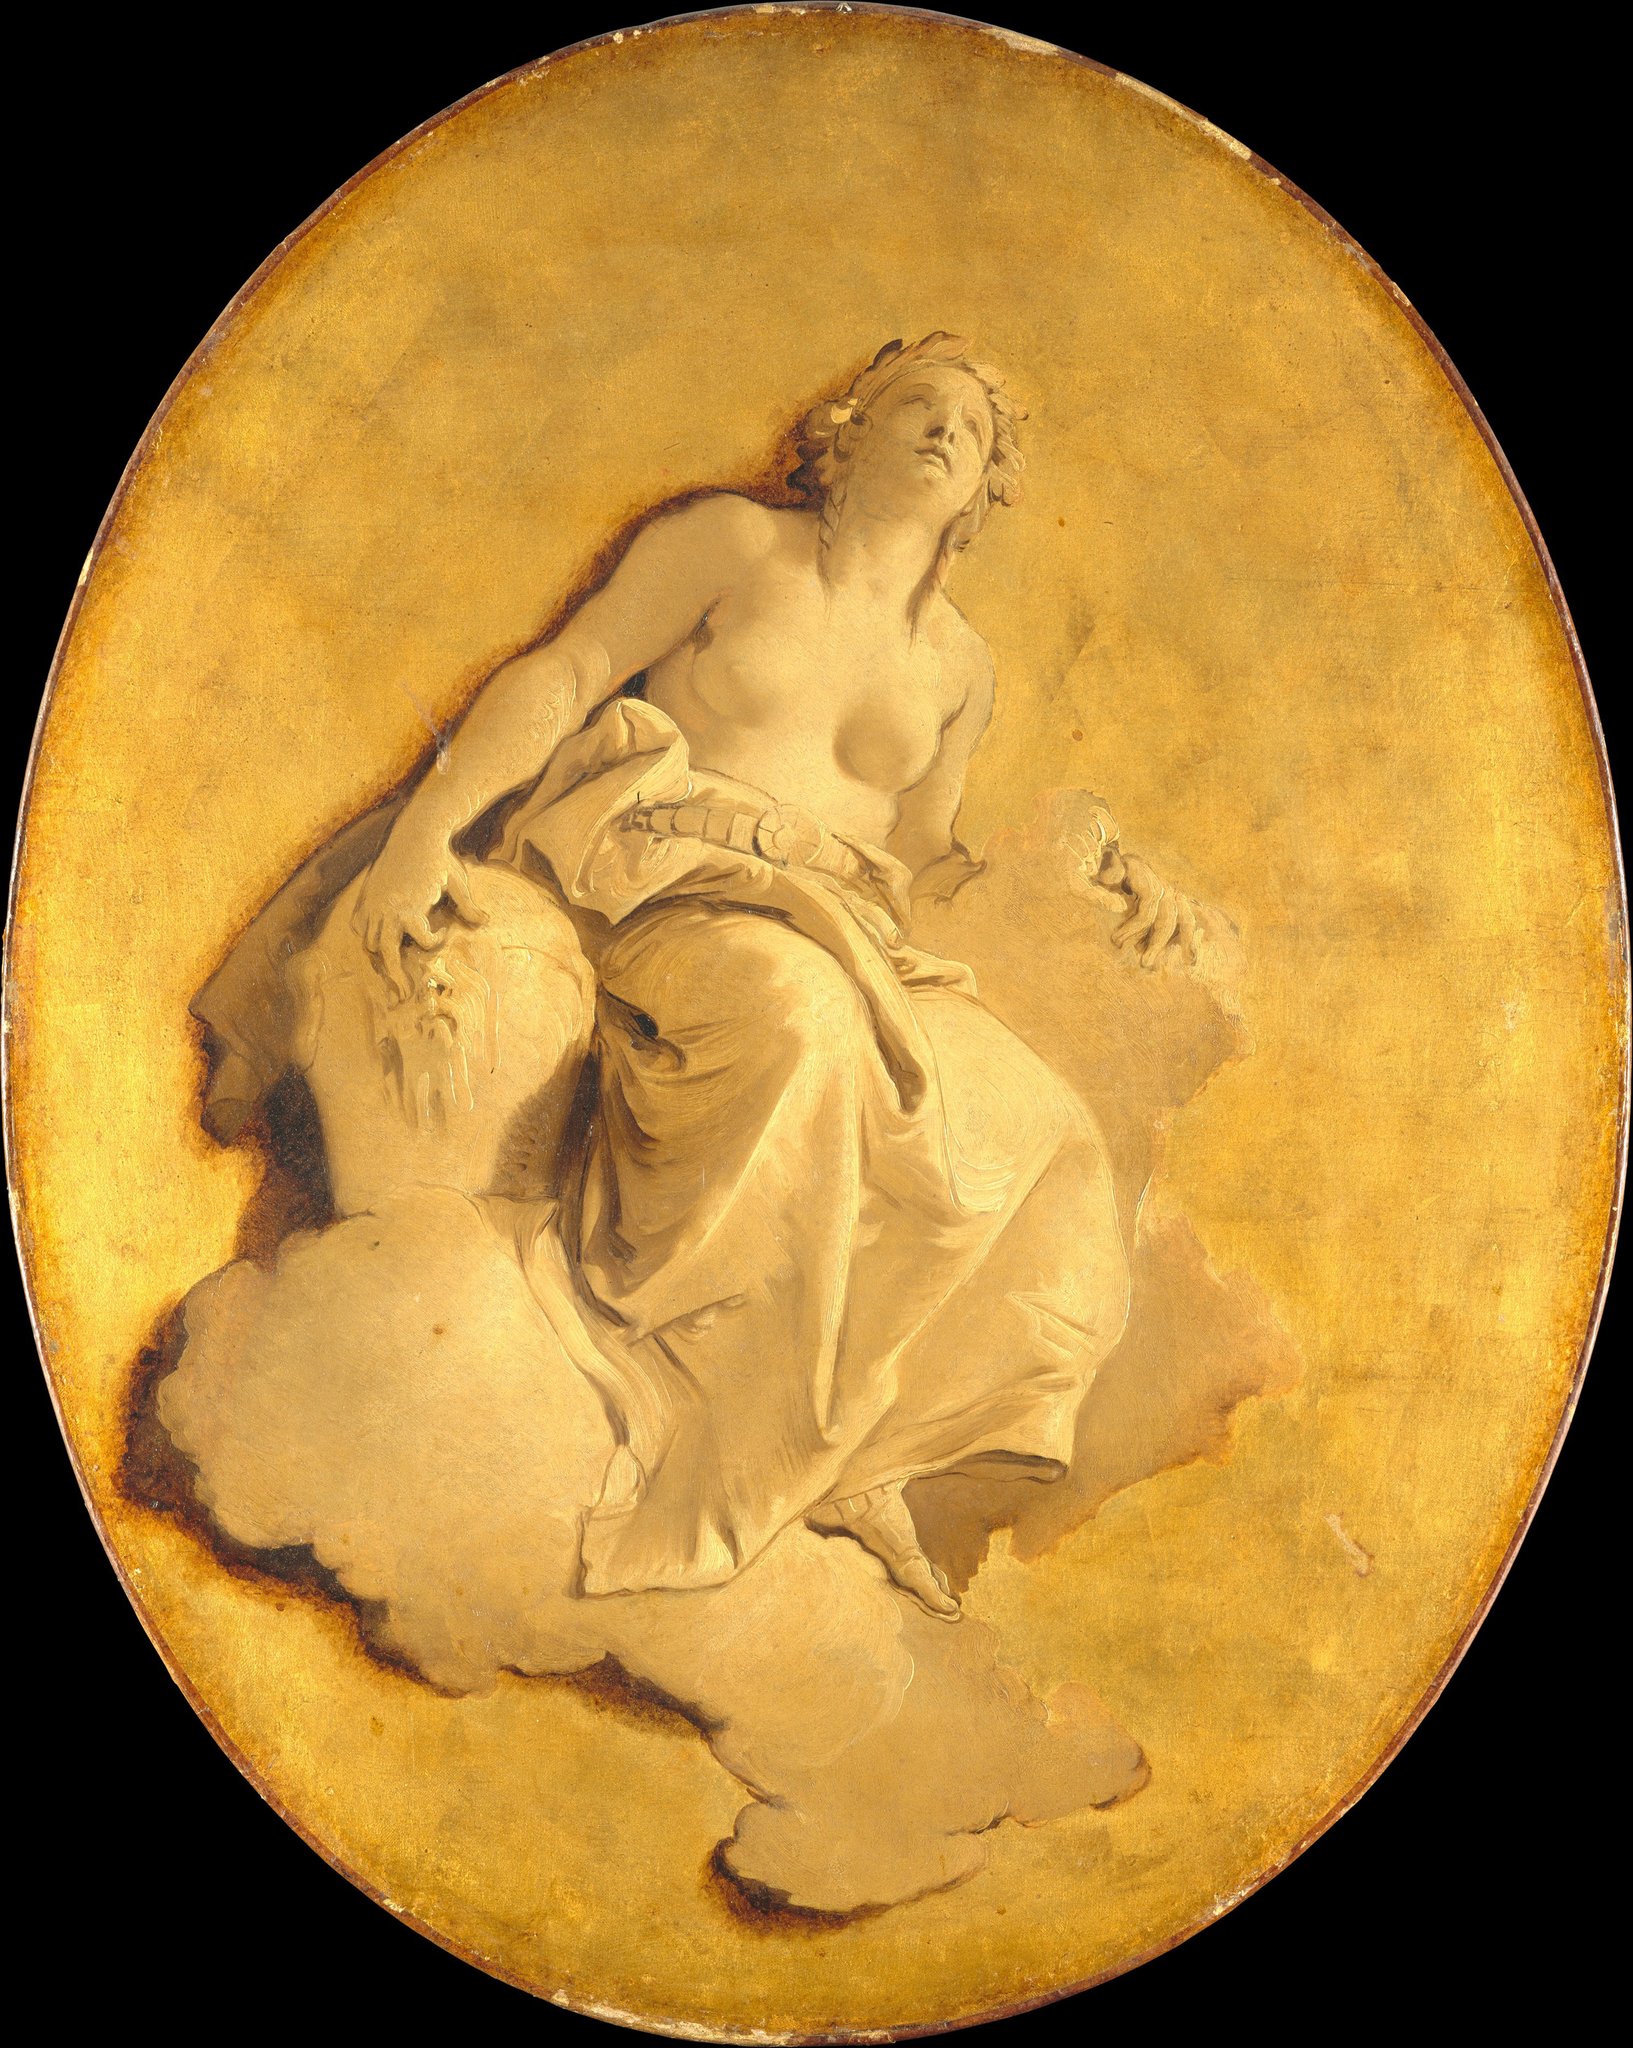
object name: painting, grisaille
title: A Female Allegorical Figure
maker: giovanni battista tiepolo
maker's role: artist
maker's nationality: italian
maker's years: 1696-1770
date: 1740-1750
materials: canvas, gold leaf, oil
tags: female nudes,allegory